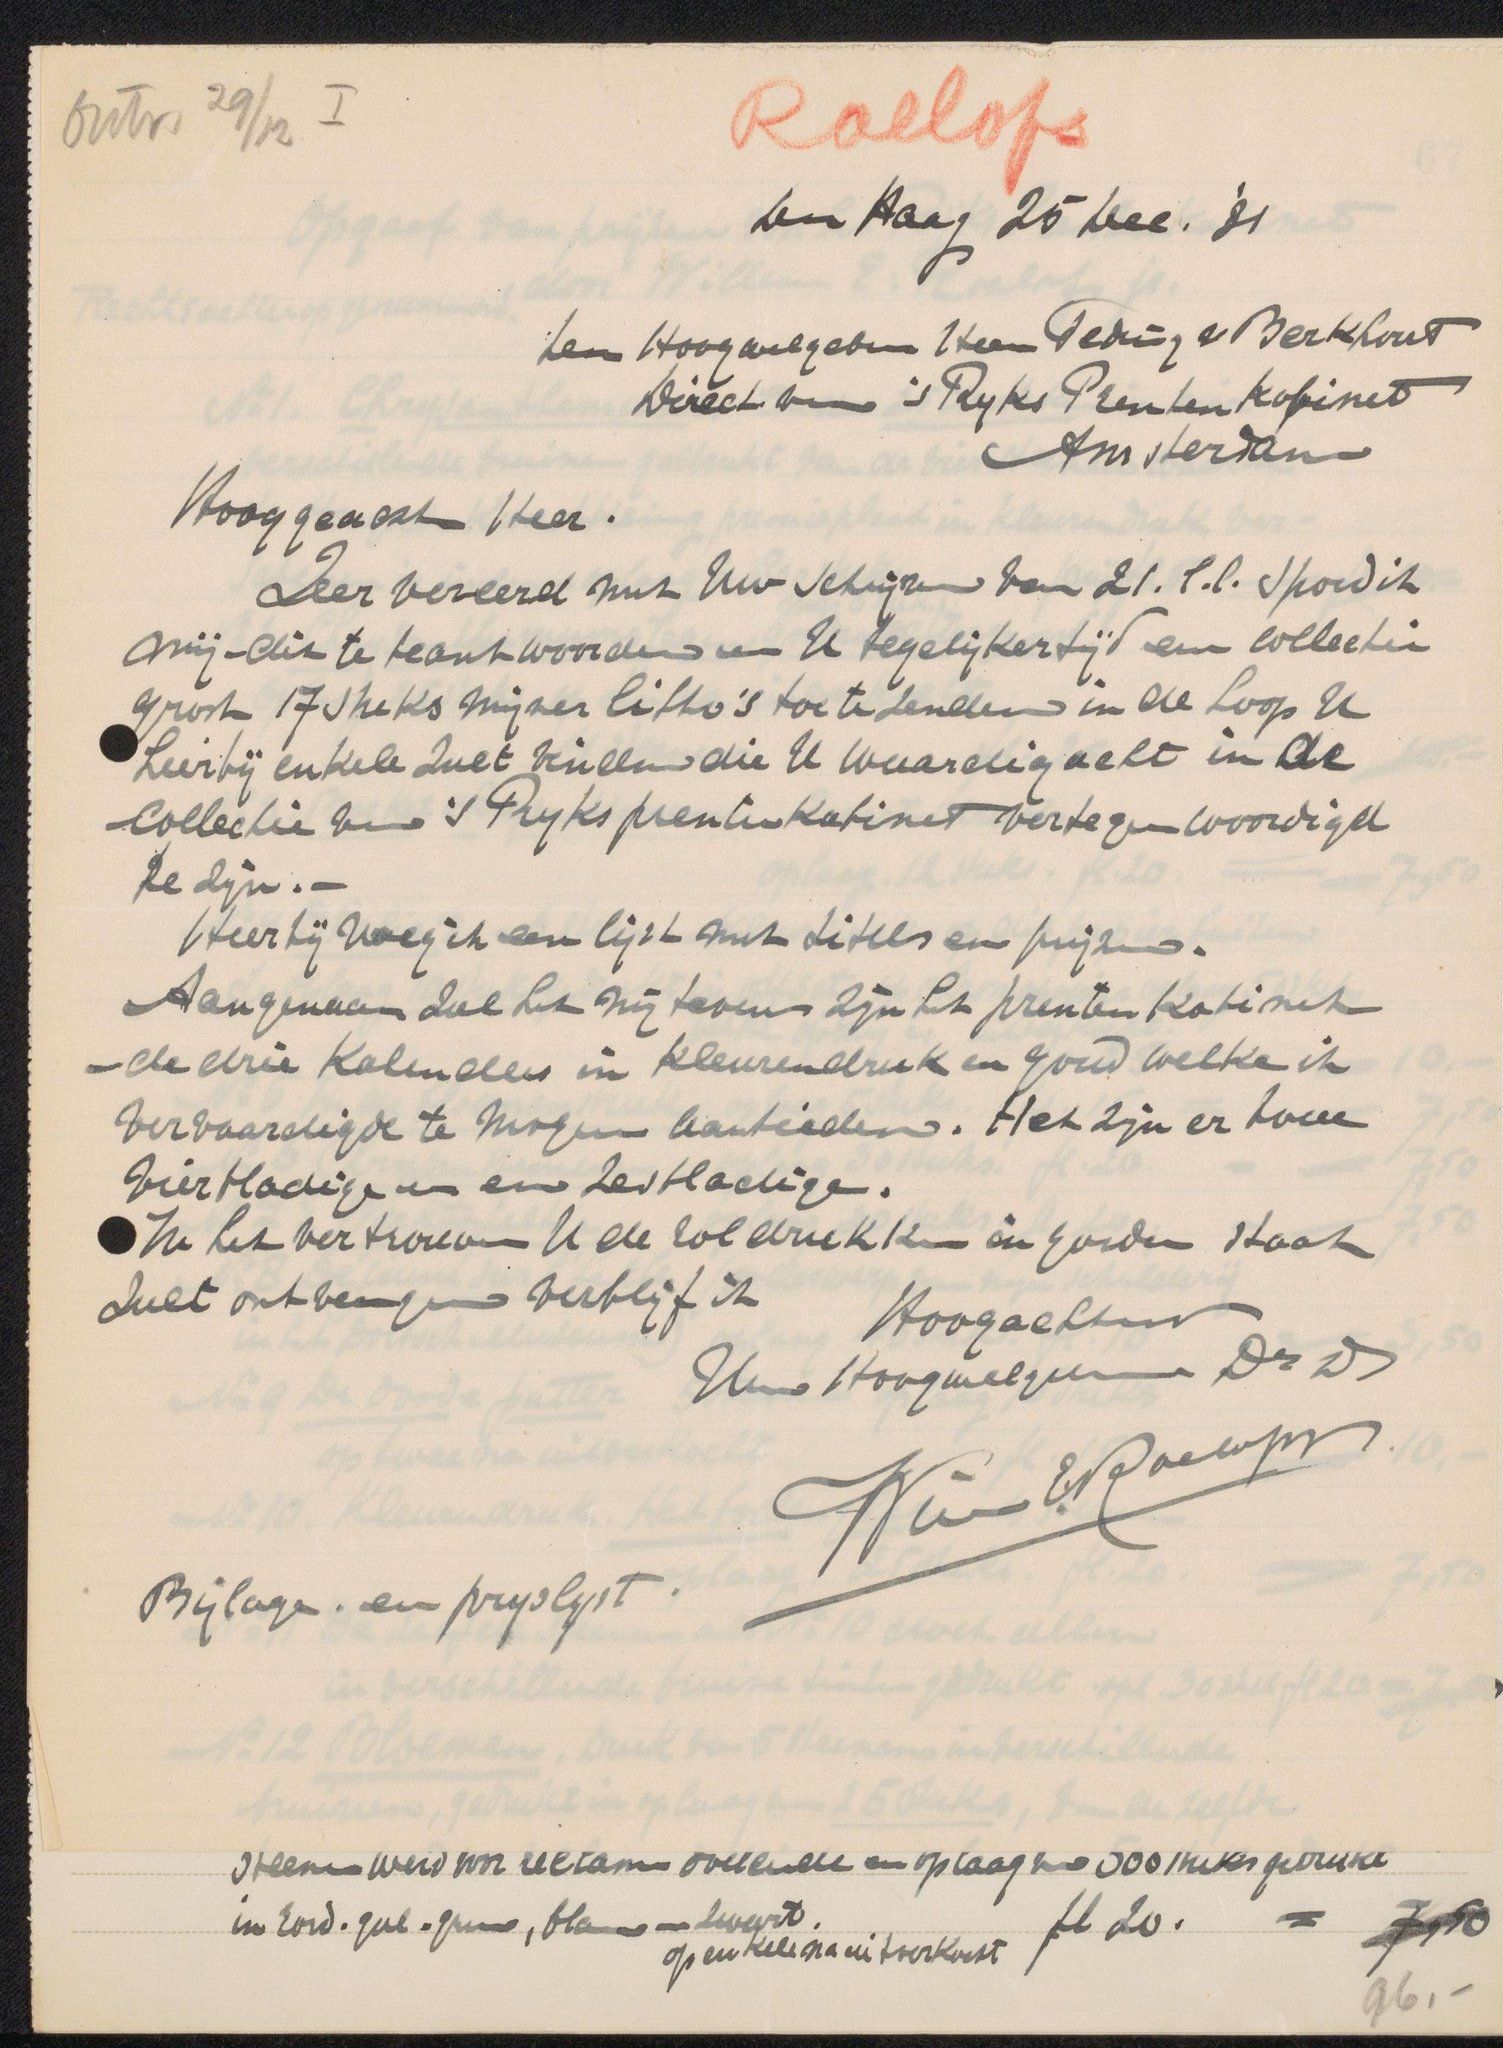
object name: letter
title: Brief aan jonkheer Hendrik Teding van Berkhout (1879-1969)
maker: willem roelofs (ii)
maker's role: draughtsman, painter, print maker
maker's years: 1874-1940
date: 1931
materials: ink, paper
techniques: pen, writing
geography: the hague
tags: haarlem, jonkheer hendrik teding van berkhout (1879-1969), art trade, art shop, drawing, money